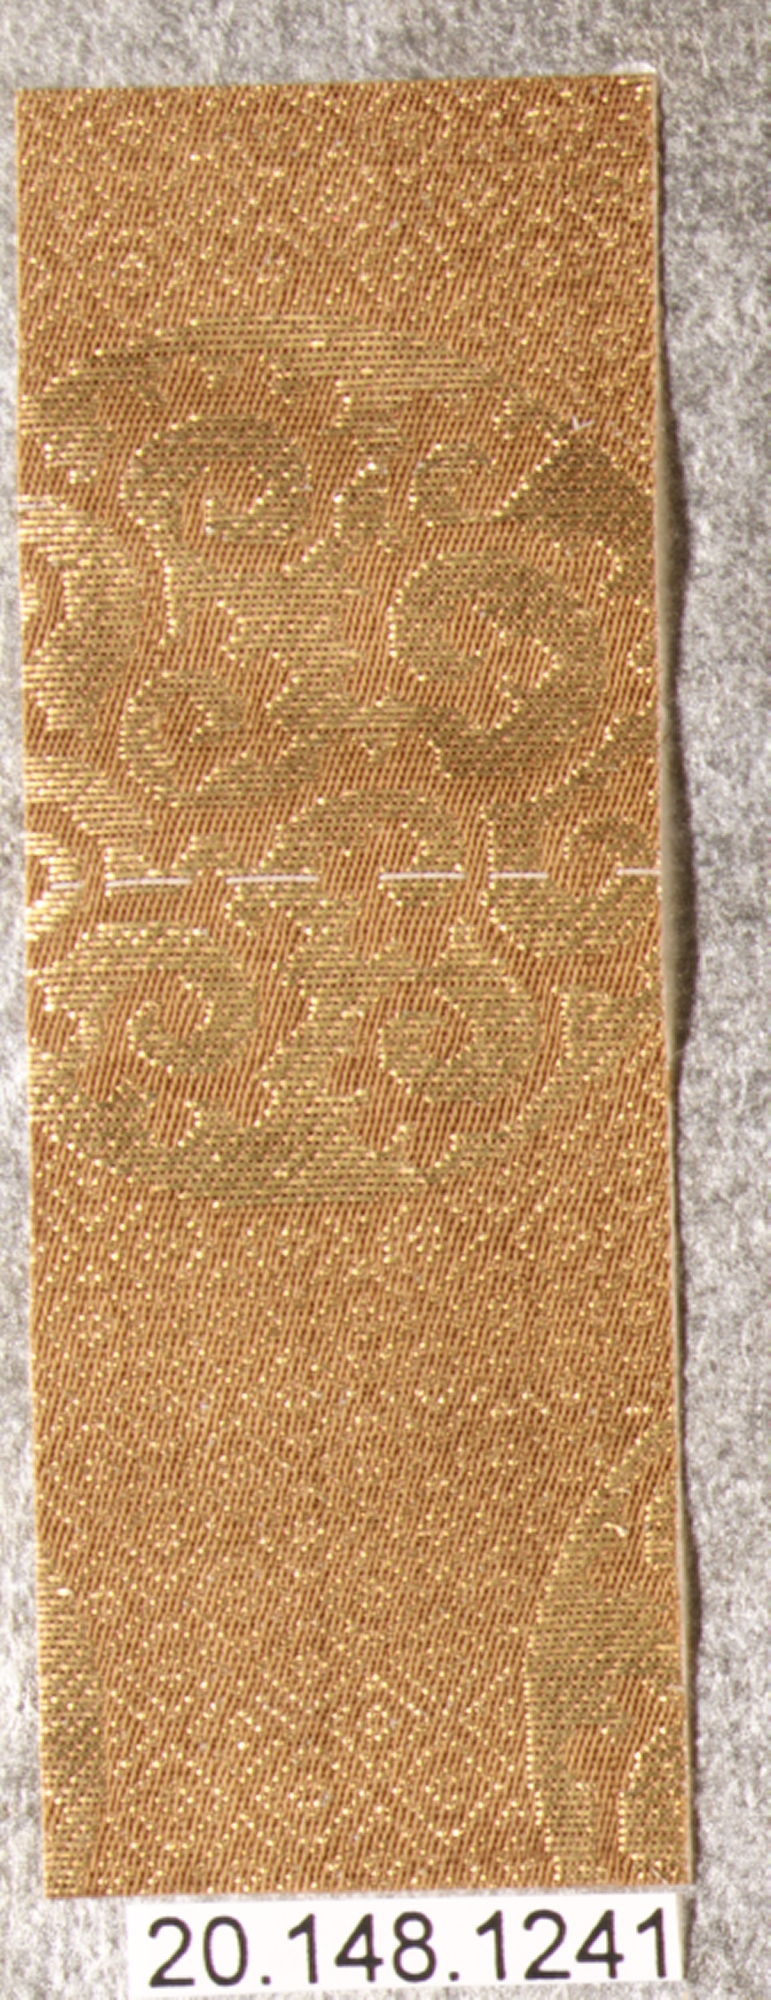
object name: piece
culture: japanese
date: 1801-1900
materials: silk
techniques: compound weave